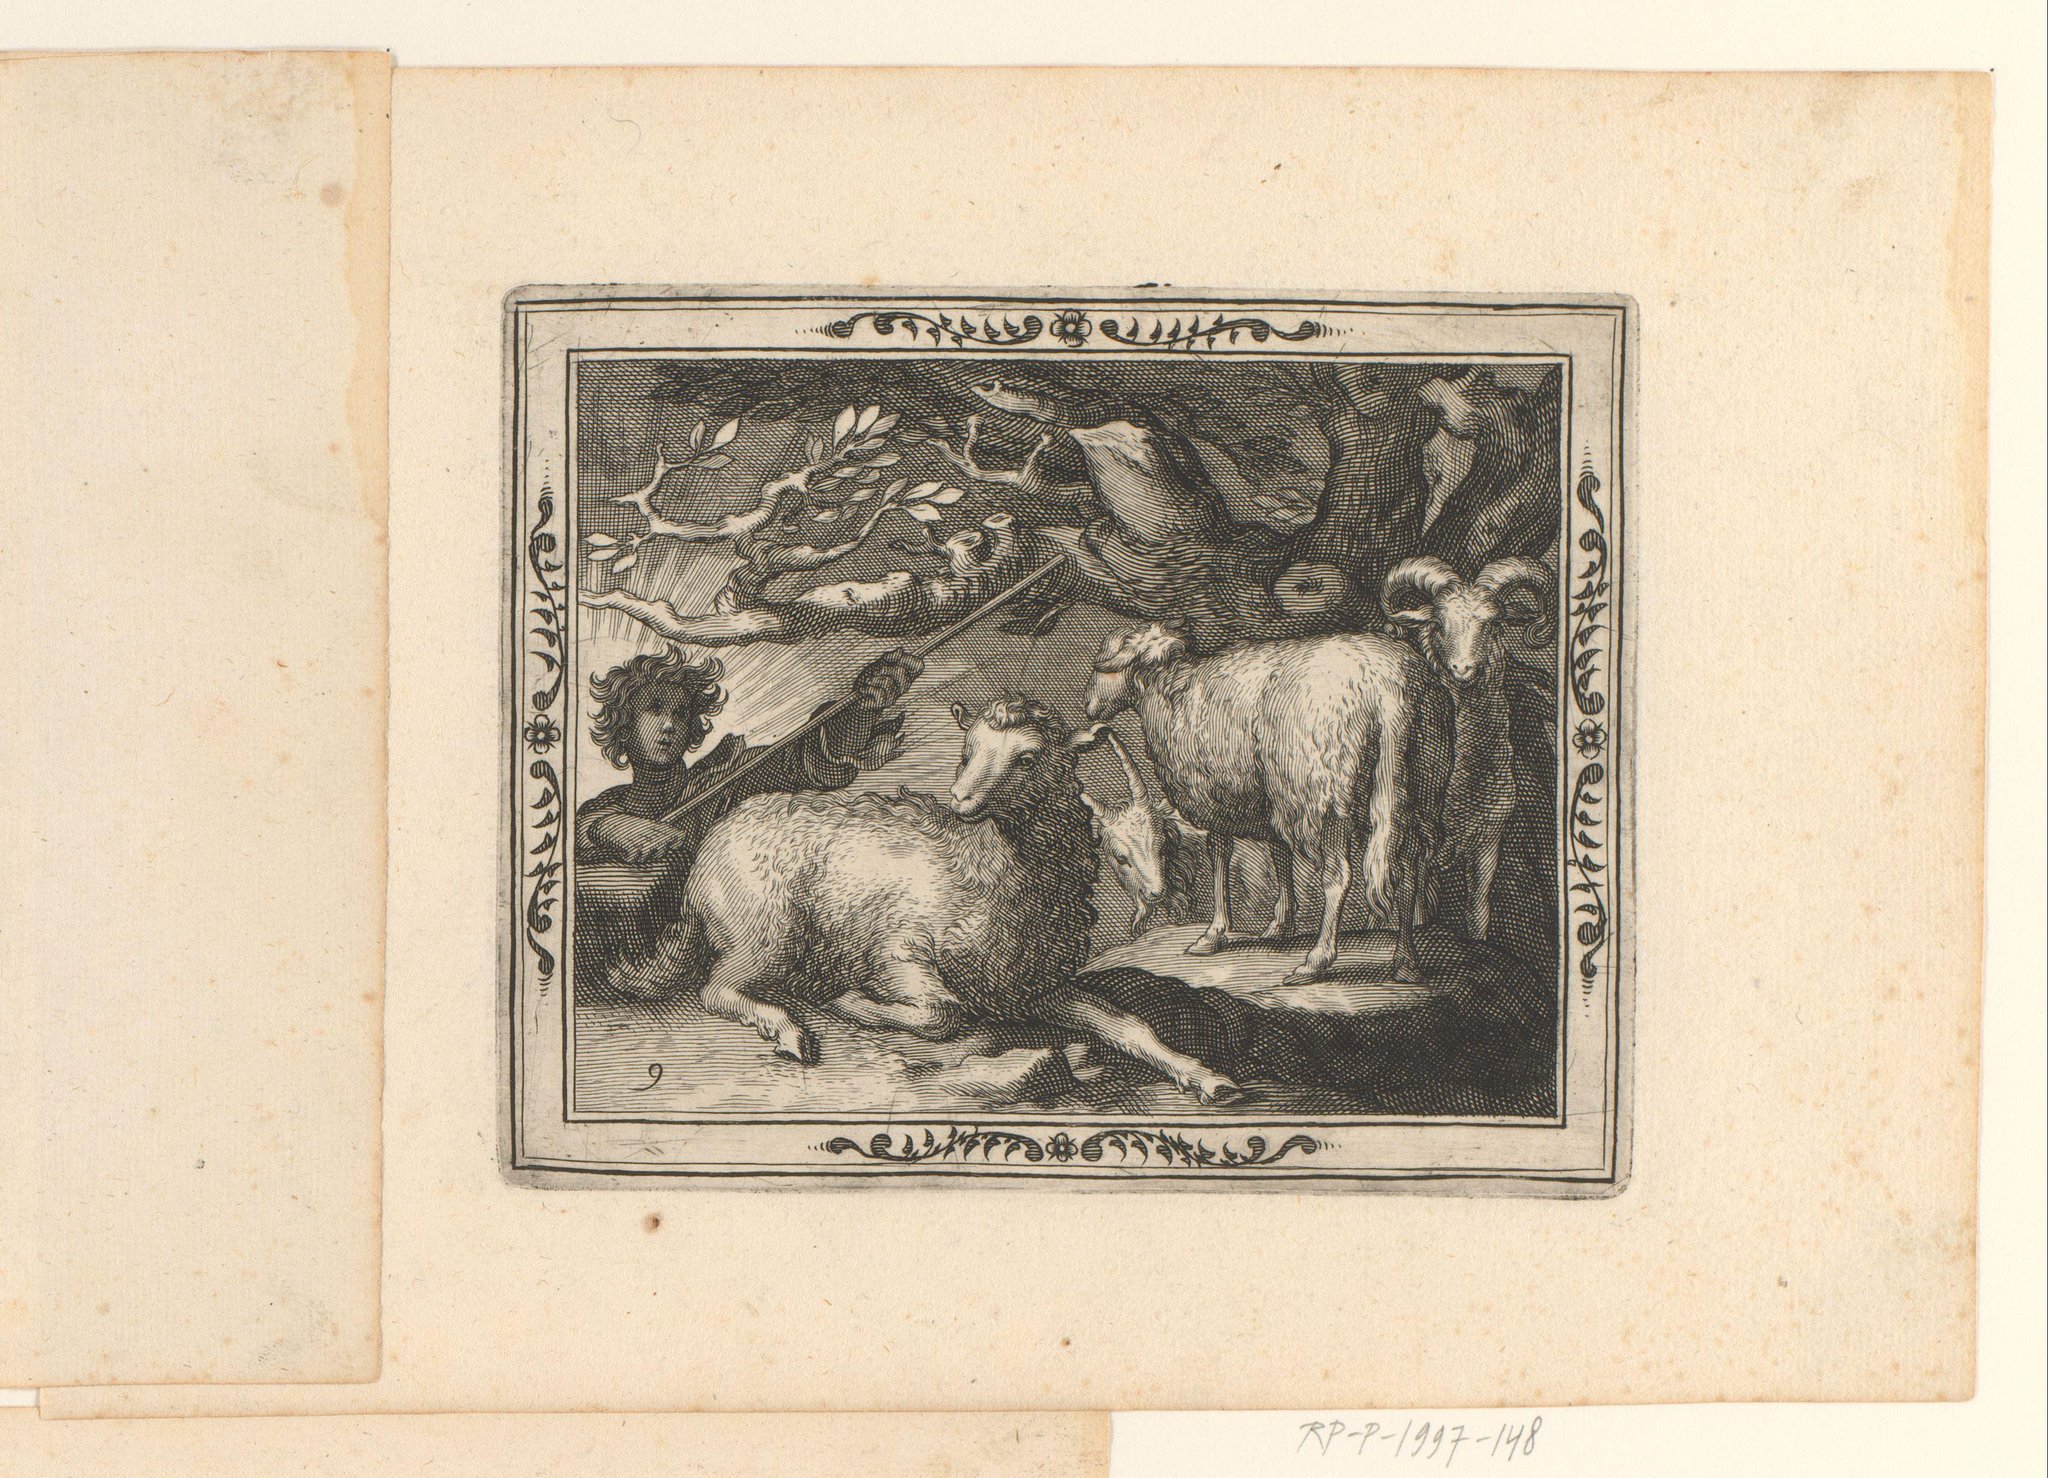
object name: print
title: Schapen met herder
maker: jean leclerc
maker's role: print maker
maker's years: 1587-1633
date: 1597-1633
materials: paper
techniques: engraving, intaglio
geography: france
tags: cattle driving, cattle driver, sheep